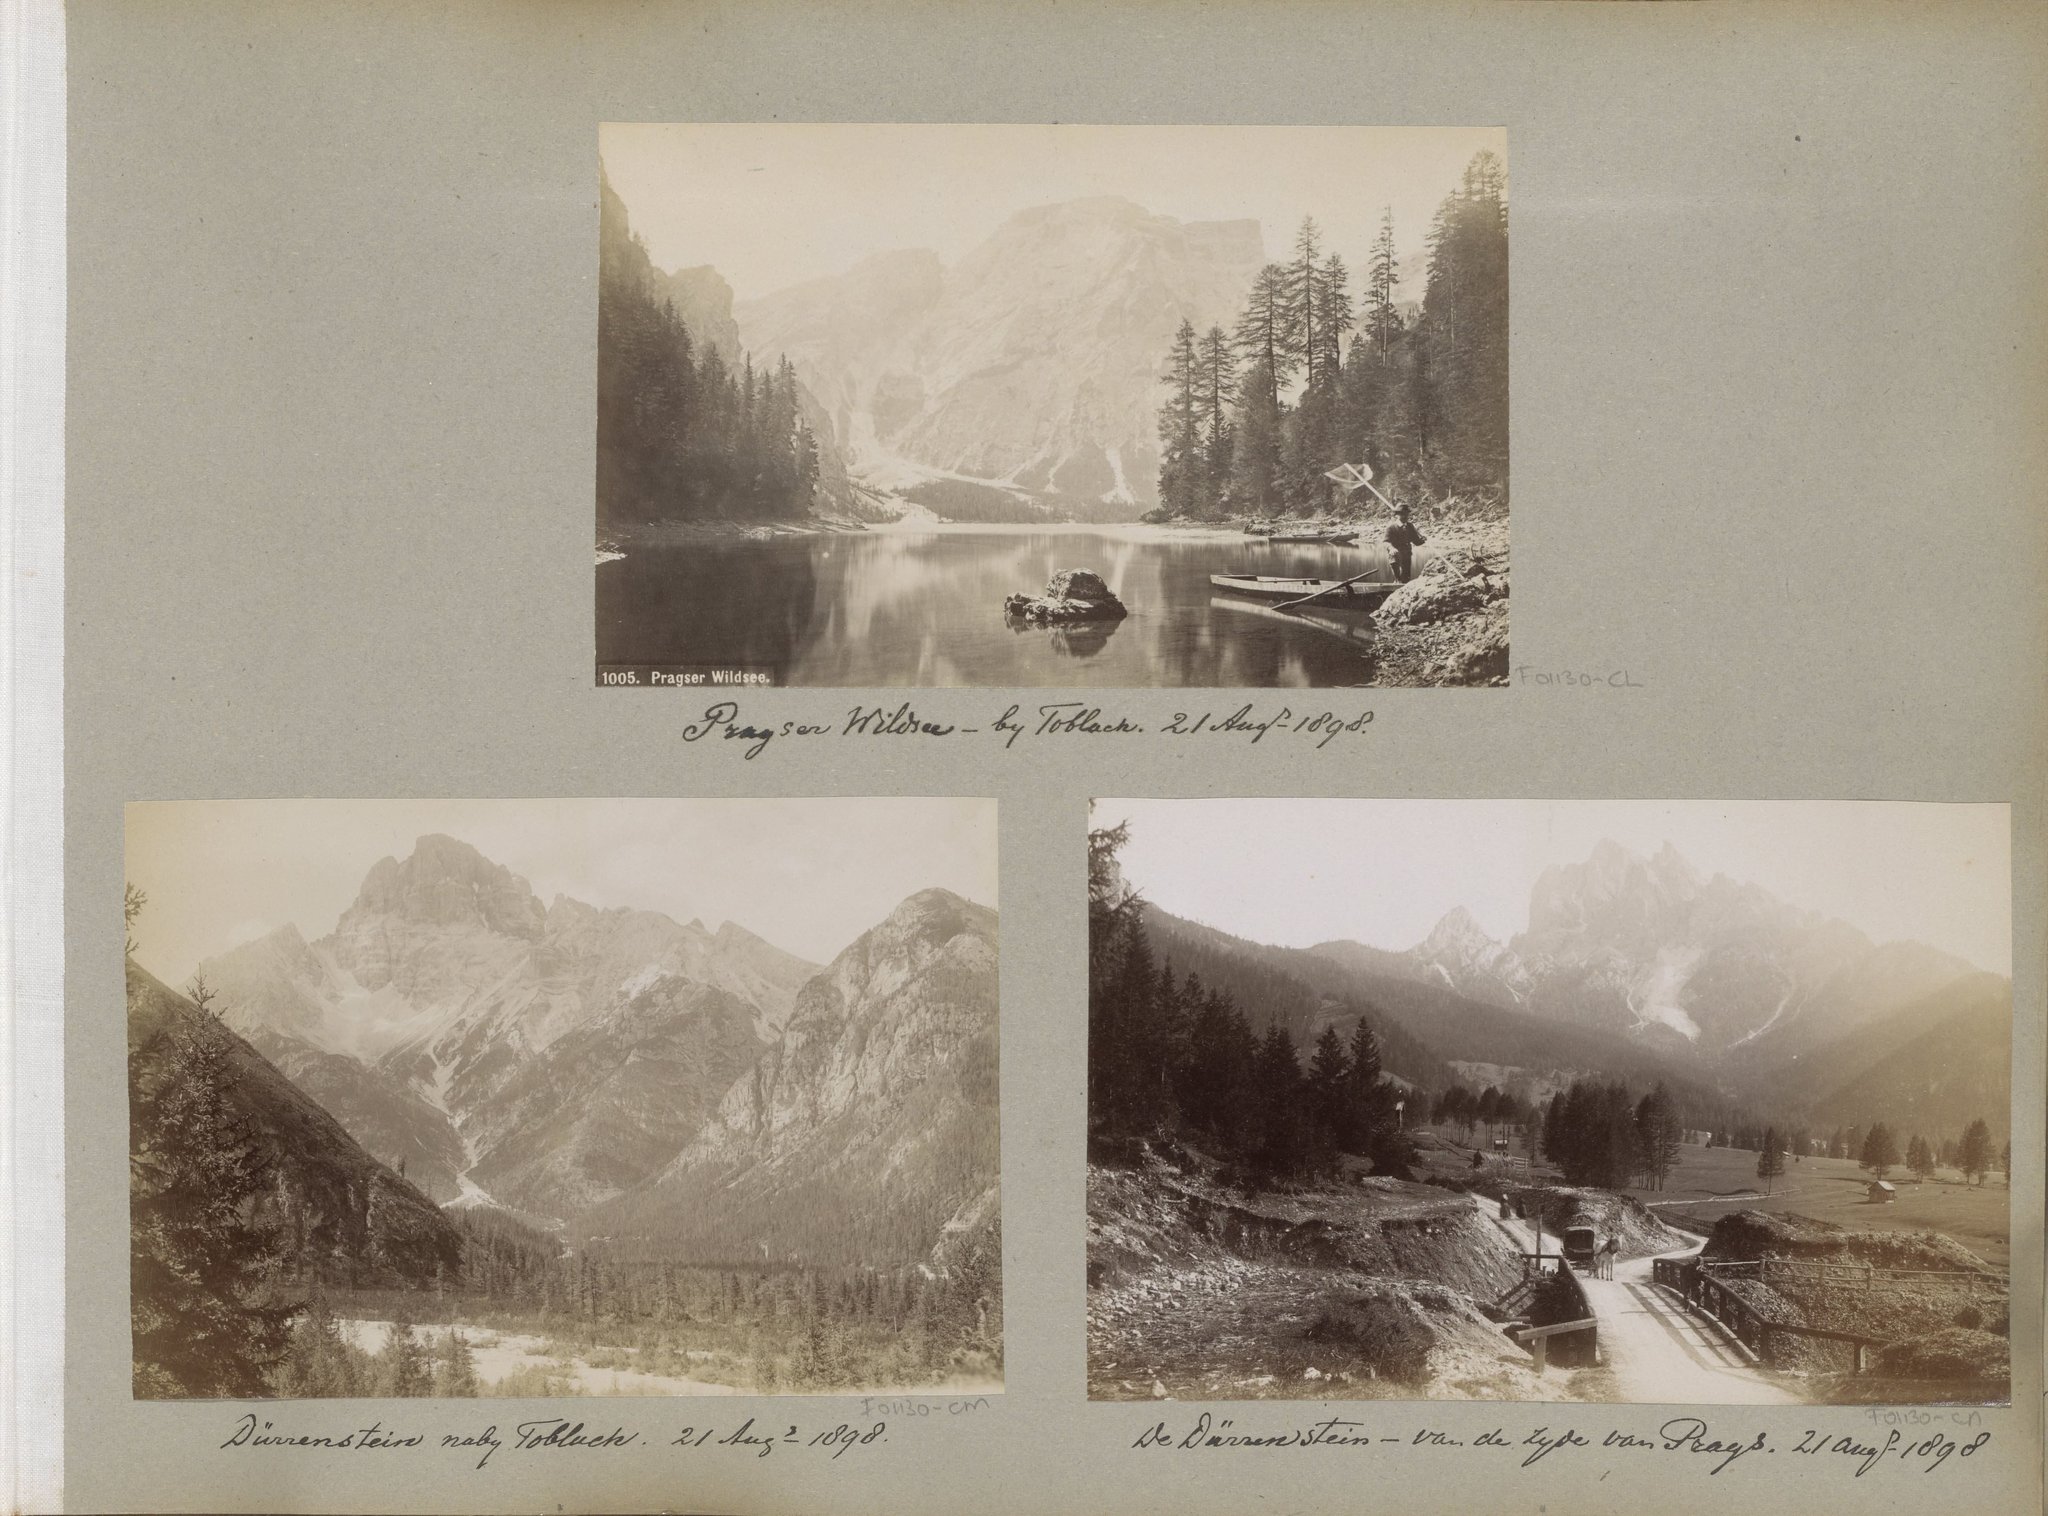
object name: album leaf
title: Pragser Wildsee.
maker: Anonymous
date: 1880-1898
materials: paper, photographic support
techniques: albumen print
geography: pragser wildsee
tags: mountain-top, peak (+ landscape with figures, staffage), rowing-boat, canoe, etc., lake, angling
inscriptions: negative number: ‘1005’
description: Onderdeel van Reisalbum met foto's van bezienswaardigheden in Frankrijk, Spanje, Italië, Duitsland, Zwitserland en Oostenrijk.